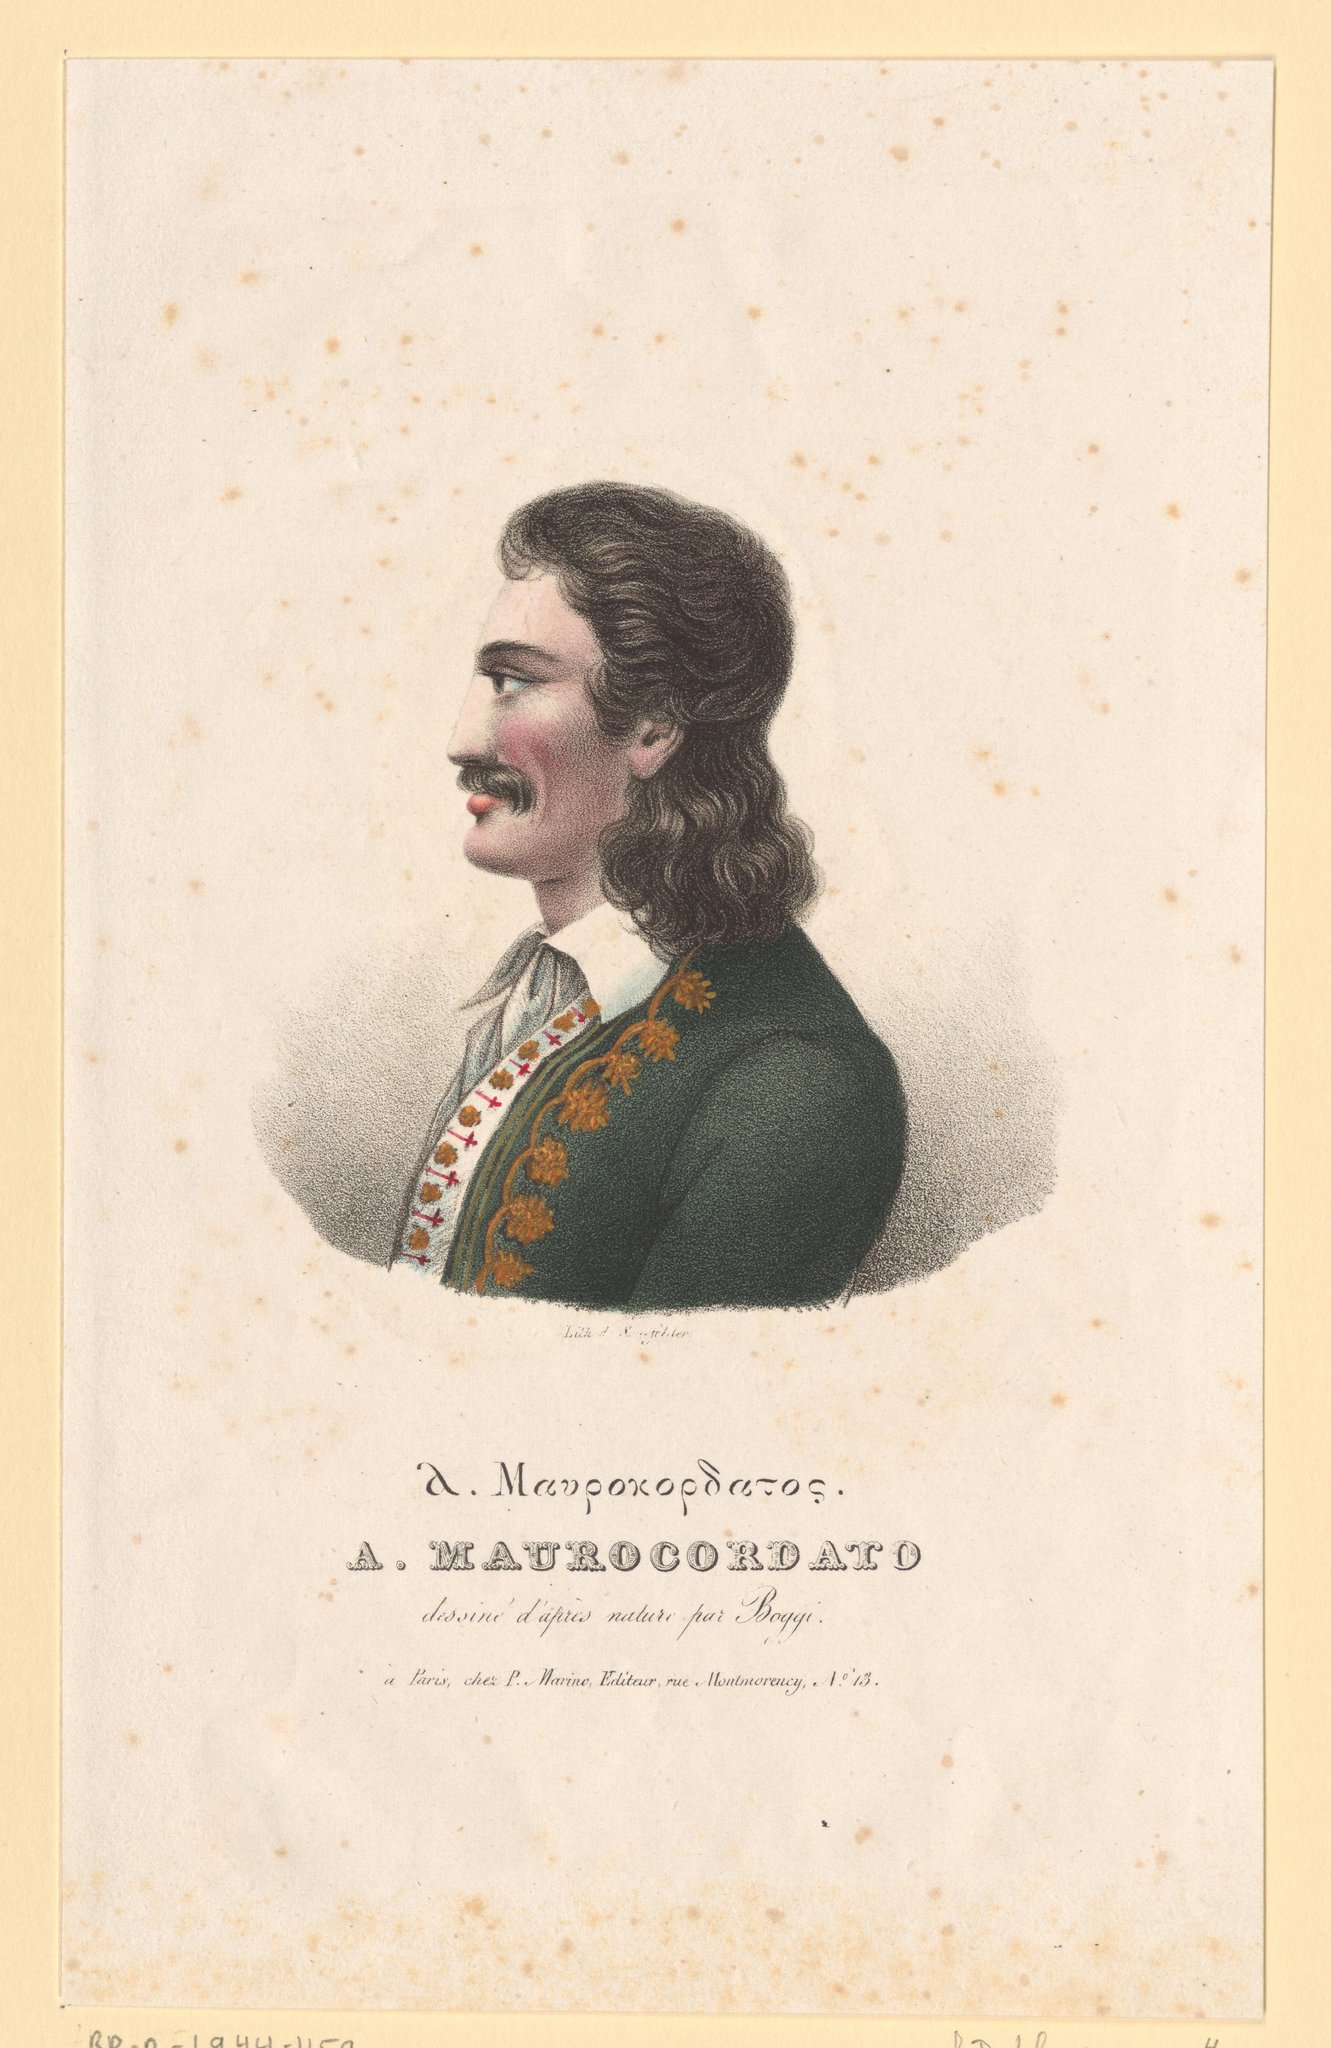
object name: print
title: Portret van Alexandros Mavrokordatos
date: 1822-1834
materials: paper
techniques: hand coloring, lithograph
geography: paris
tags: politician, historical persons, politician, e.g. party leader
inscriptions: collector's mark: Lugt 2228